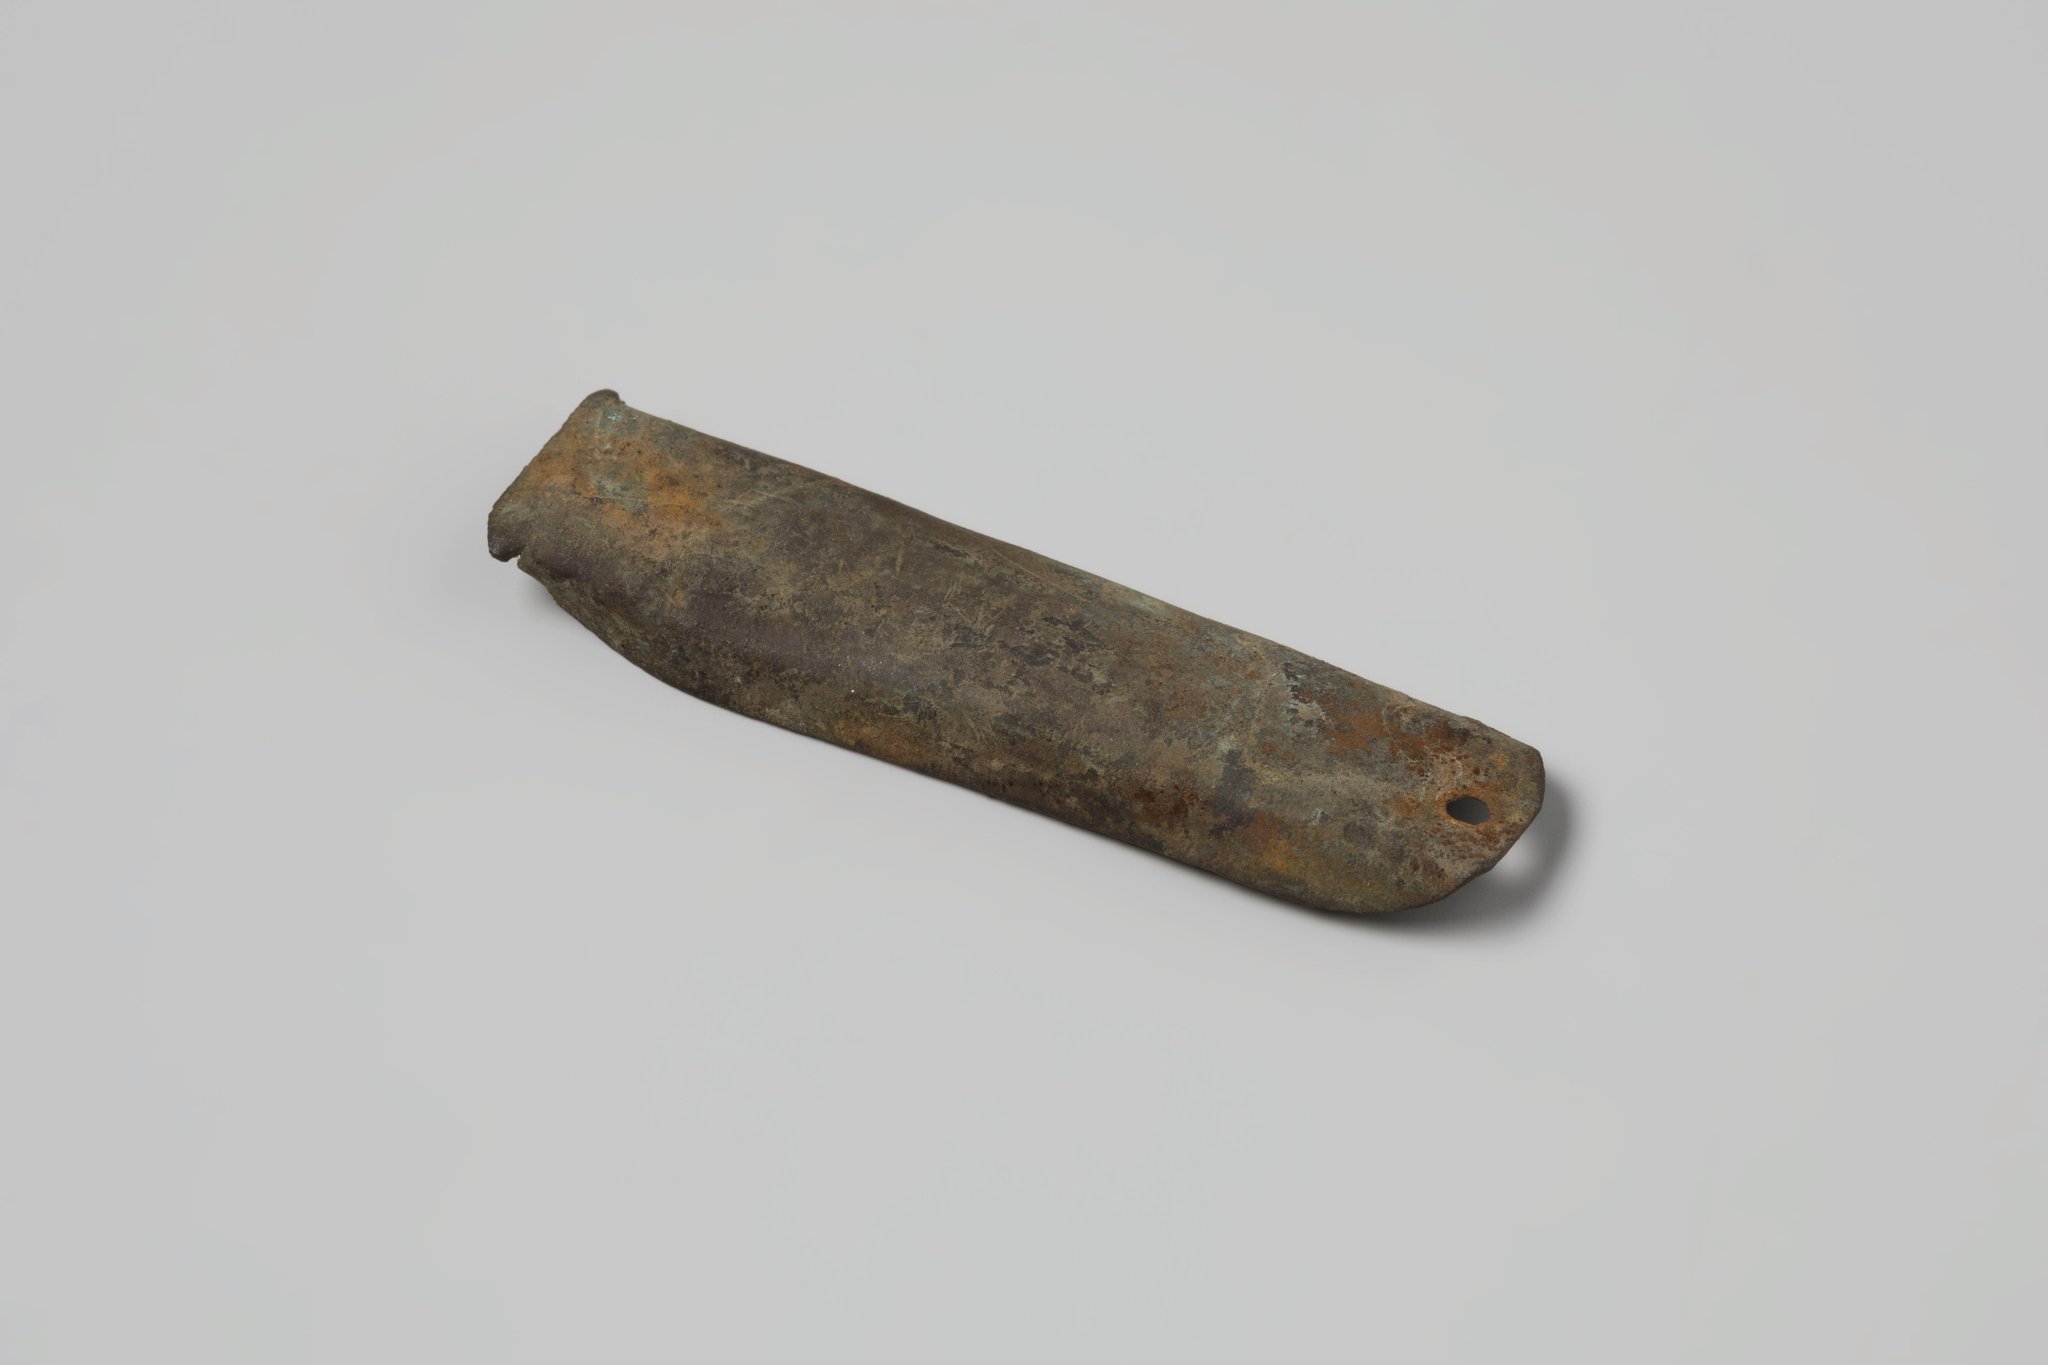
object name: beslag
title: Hoekbeslag uit het wrak van de Oost-Indiëvaarder Hollandia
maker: Anonymous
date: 1700-1743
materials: copper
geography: netherlands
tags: verenigde oostindische compagnie, hollandia (schip), annet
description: Corner-fitting; fragm, id. NG 1980-27H801: 1 half.